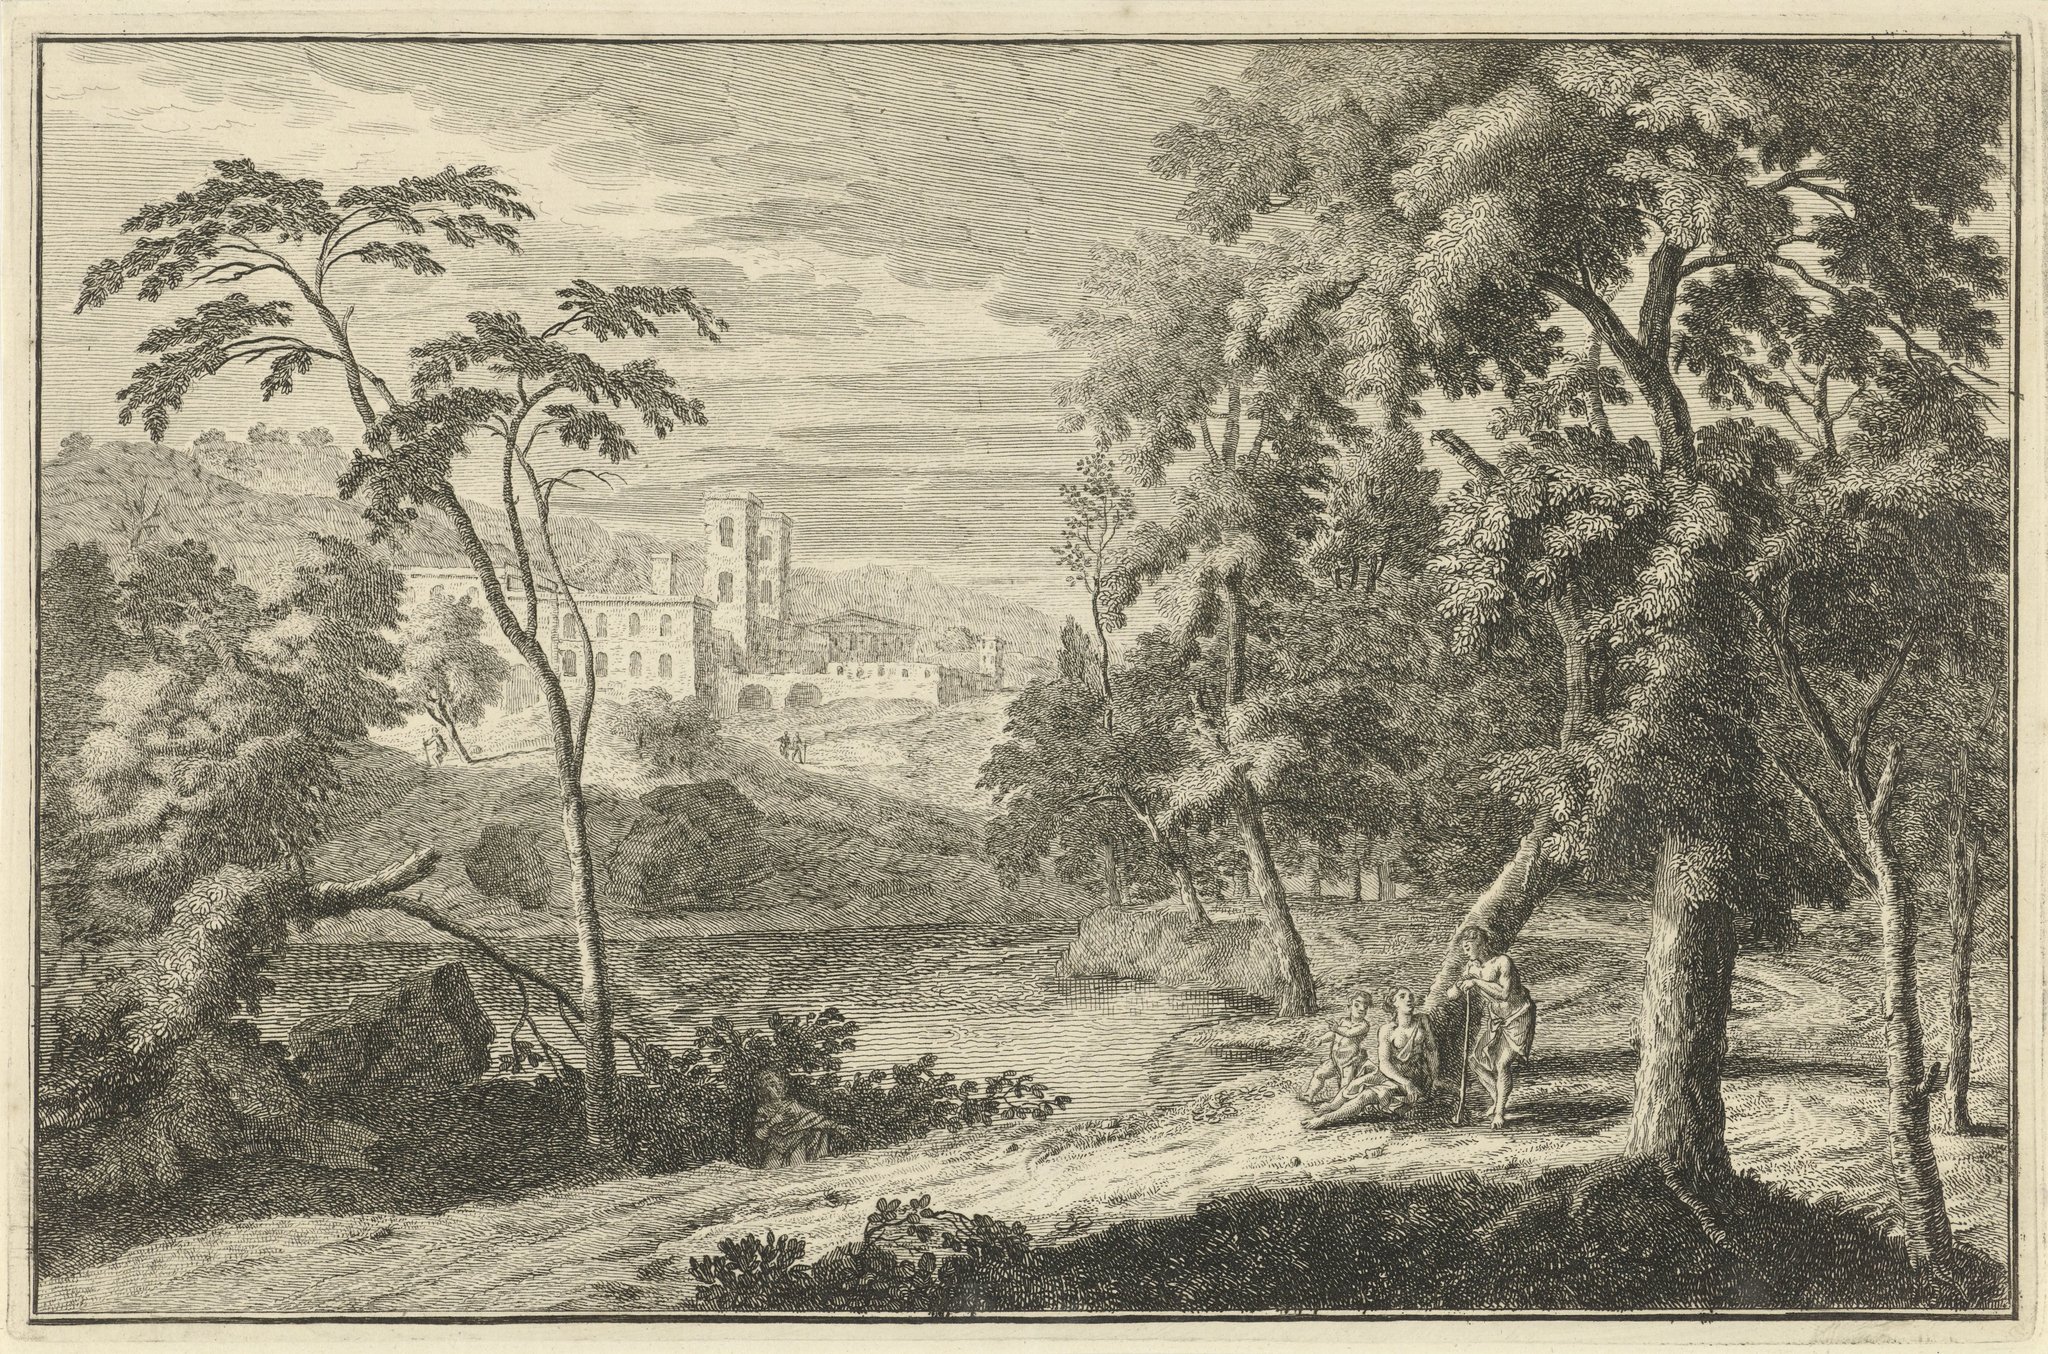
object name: print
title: Arcadisch rivierlandschap met man, vrouw en kind op de oever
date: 1710-1747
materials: paper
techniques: etching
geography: amsterdam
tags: landscapes with waters, waterscapes, seascapes (in the temperate zone), prospect of city, town panorama, silhouette of city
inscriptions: collector's mark: Lugt 240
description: Arcadisch rivierlandschap met rechts op de oever een man, vrouw en kind bij een boom. In de verte ligt een stad of dorp. De prent maakt mogelijk deel uit van een 40-delige serie prenten met voorstellingen van Italiaanse en Duitse landschappen.